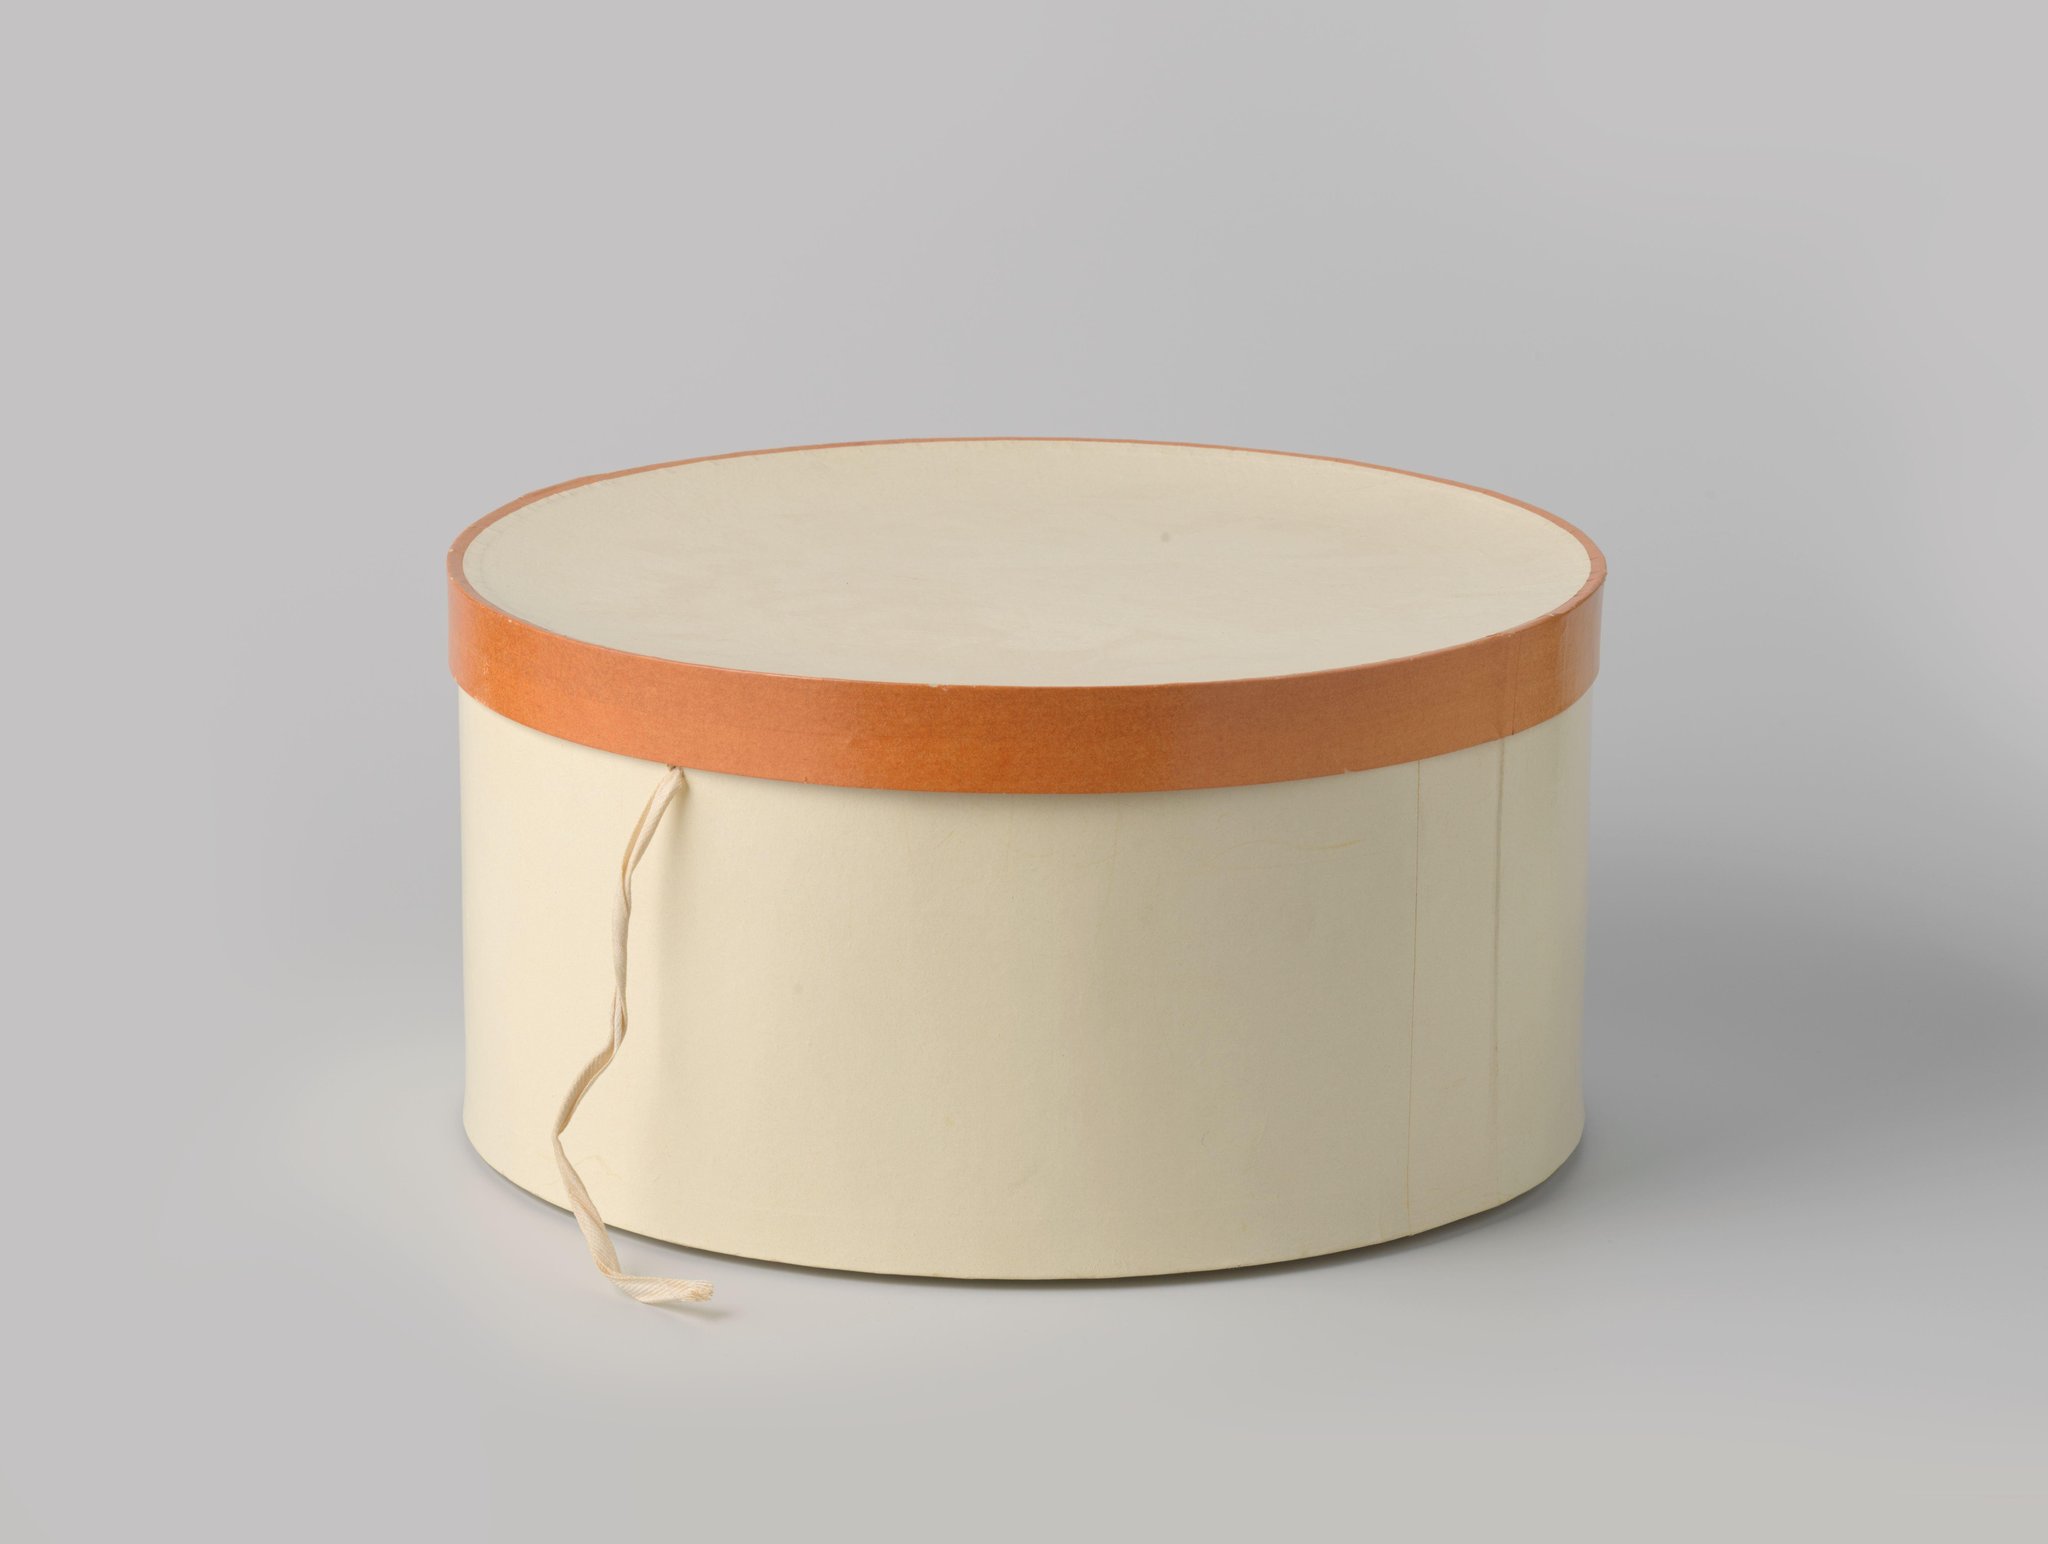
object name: verpakking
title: Ronde hoedendoos van karton beplakt met crèmekleurig papier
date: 1950-1959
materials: cardboard, paper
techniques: pasting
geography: hilversum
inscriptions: name: ‘Elysee Modes // HILVERSUM // UTRECHT// HAARLEM’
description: Ronde hoedendoos van karton beplakt met crèmekleurig papier. Het losse deksel is langs de randen beplakt met goudkleurig papier. Op de doos de naam Elysee Modes. Met draaglinten.